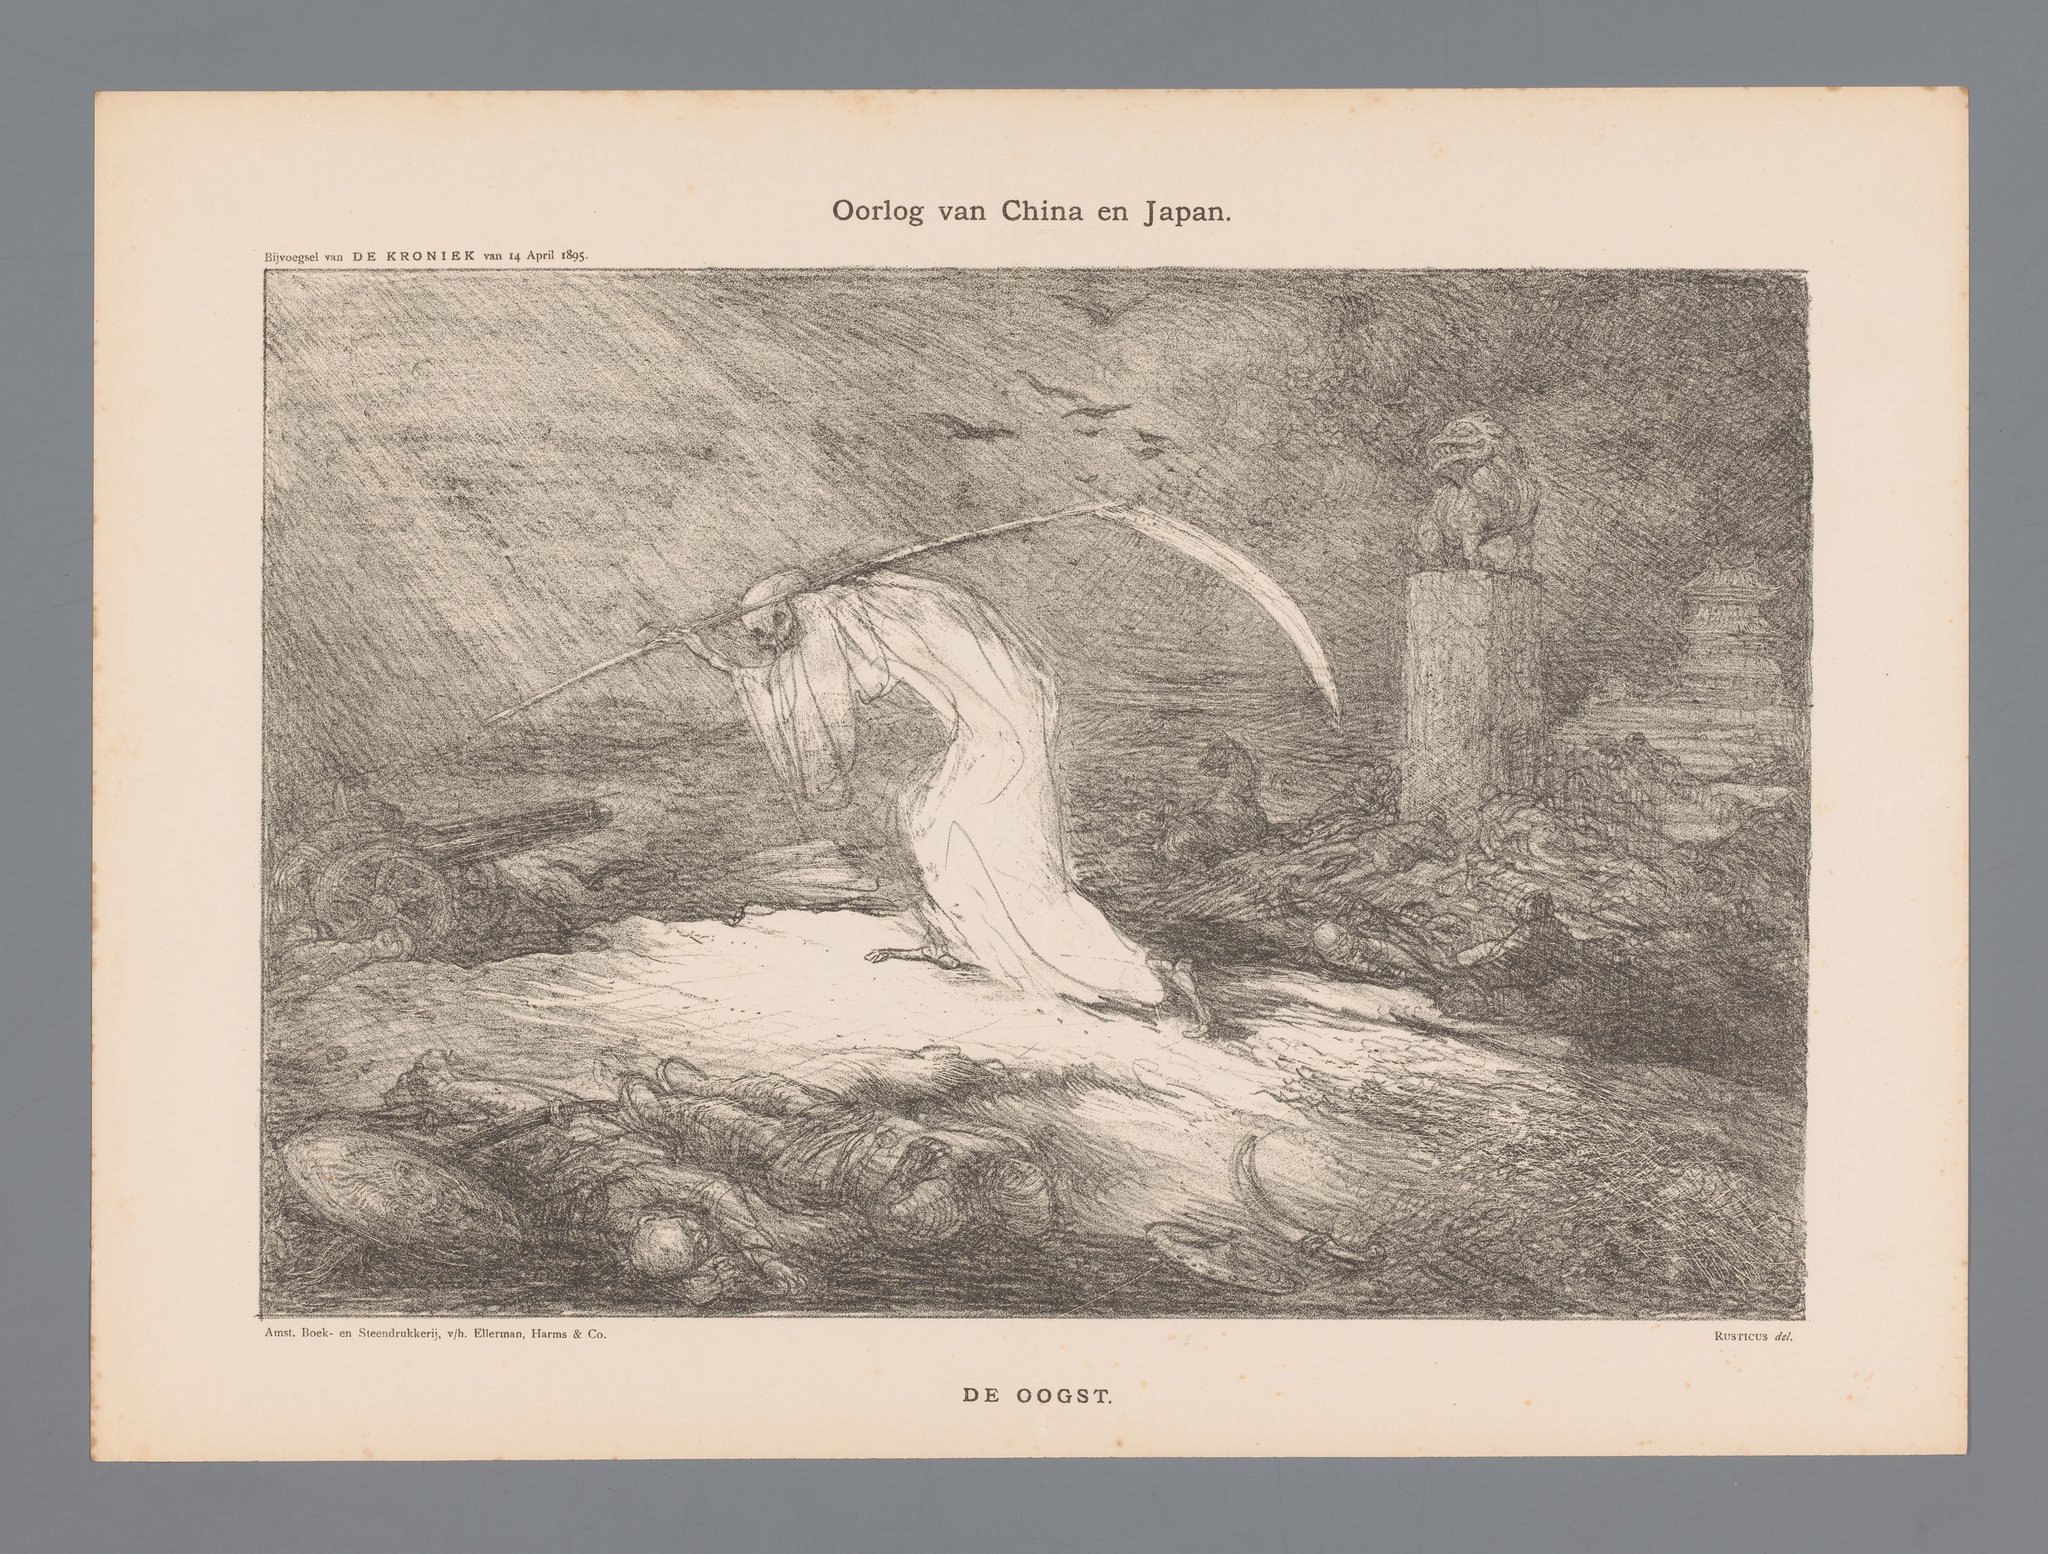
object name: cartoon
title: Oorlog van China en Japan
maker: marius bauer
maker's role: draughtsman, print maker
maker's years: 1867-1932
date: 1895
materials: paper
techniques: lithograph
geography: amsterdam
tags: death as skeleton, personifications of death; 'morte' (ripa) (+ death with scythe), political caricatures and satires, china, japan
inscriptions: date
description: Spotprent op de Eerste Chinees-Japanse Oorlog in 1894-1895. De Dood waart over het slagveld bezaaid met lijken.